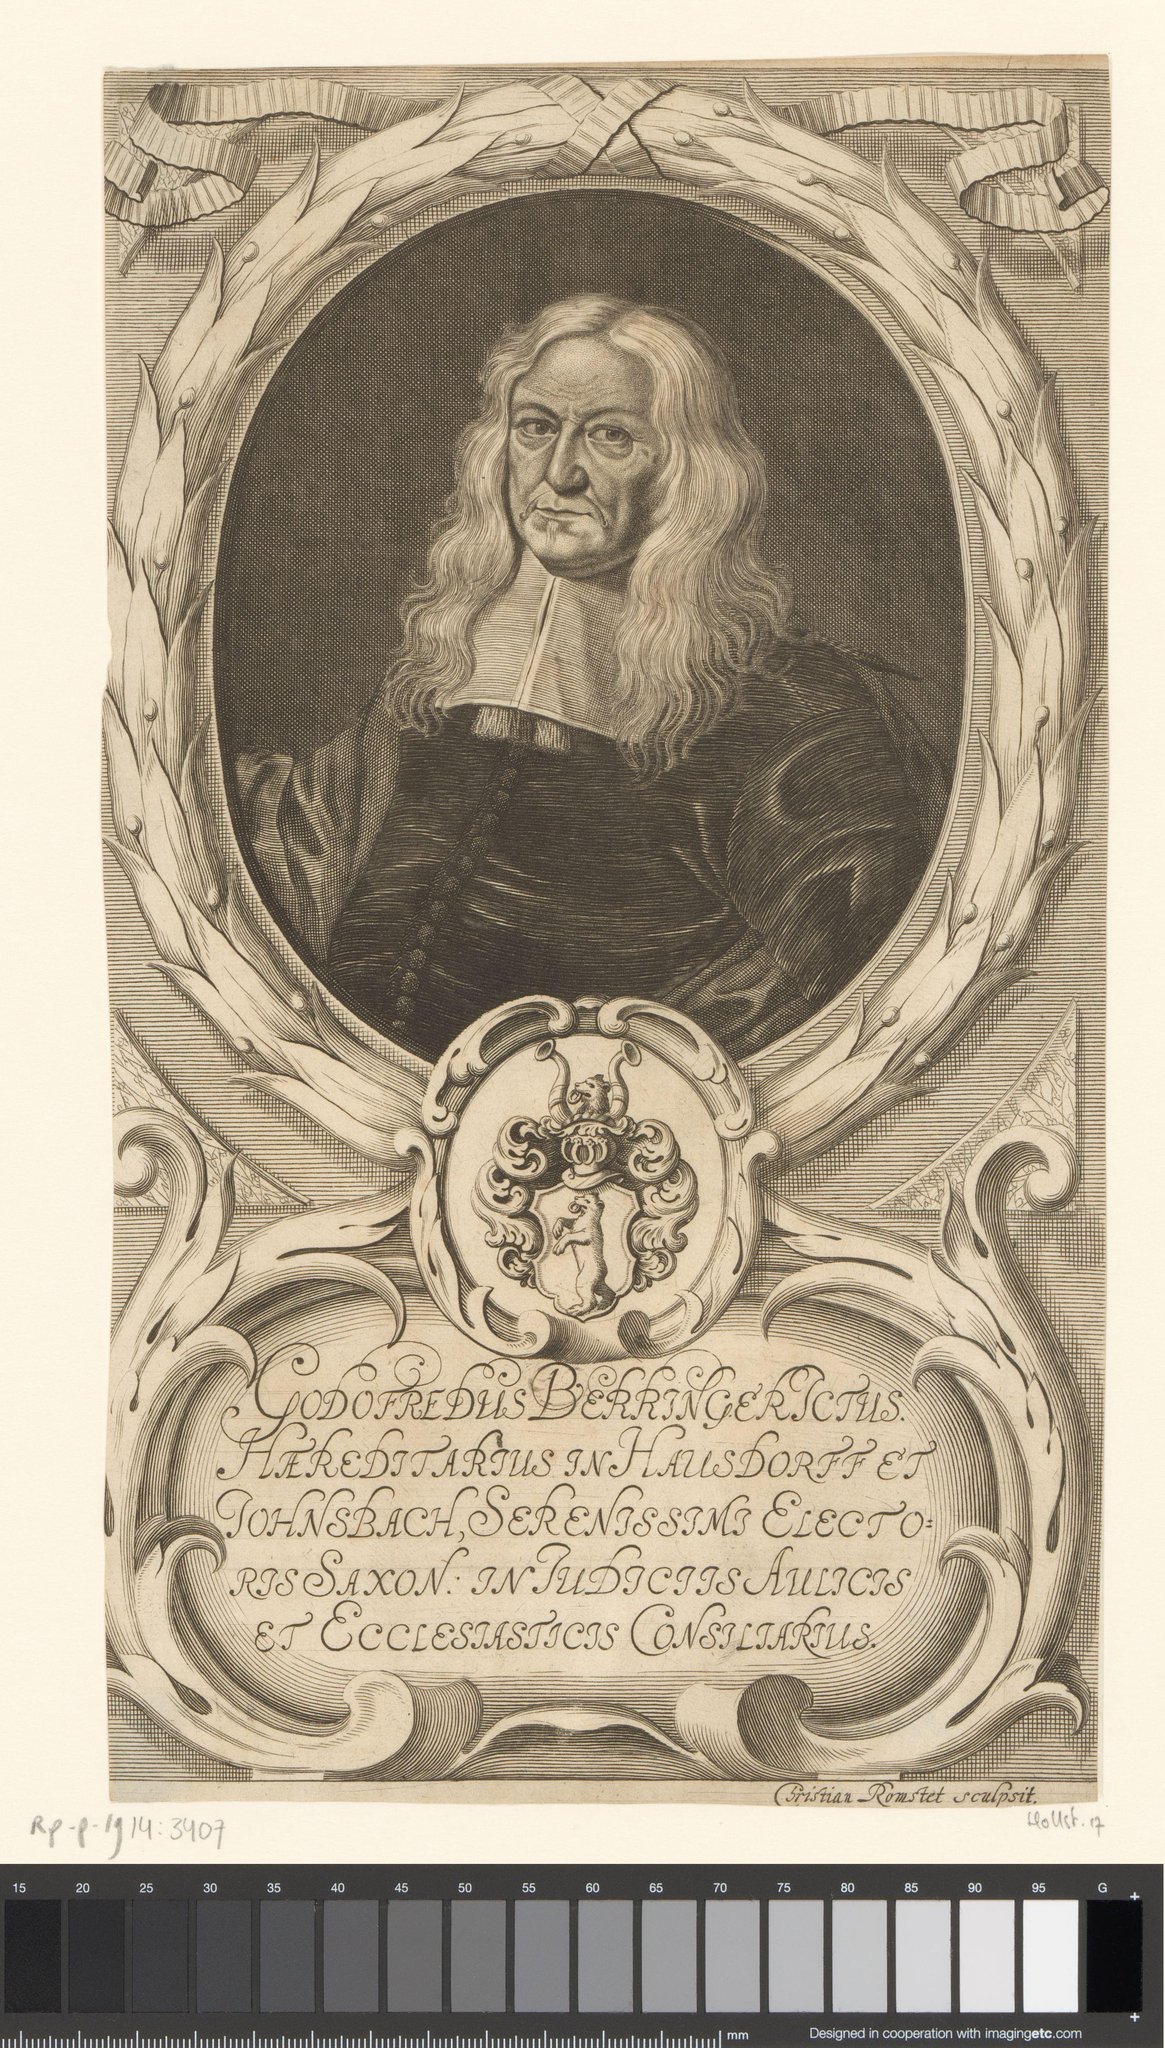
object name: print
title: Portret van Gottfried Berringer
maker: christian romstet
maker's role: print maker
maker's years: 1640-1721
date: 1665-1721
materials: paper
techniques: engraving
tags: historical persons, armorial bearing, heraldry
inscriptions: collector's mark: Lugt 2228